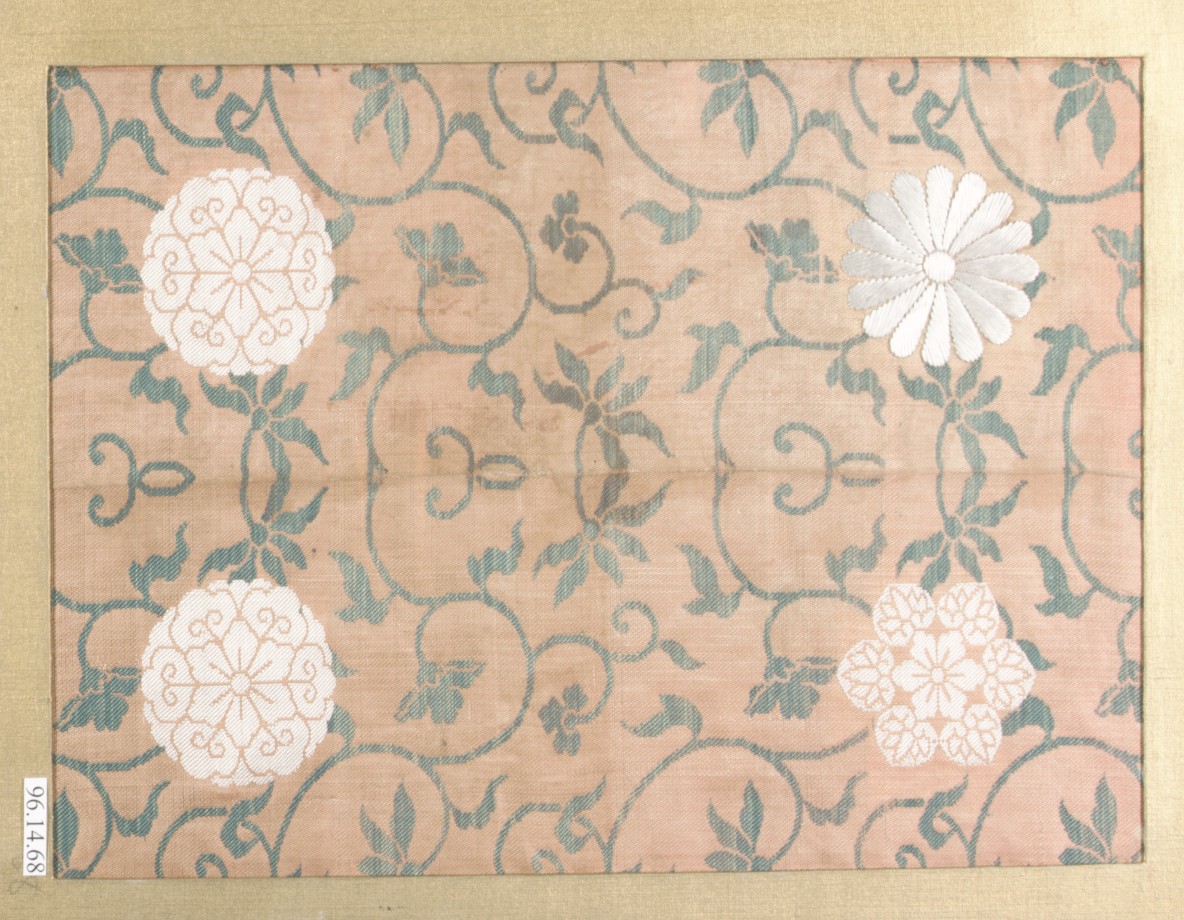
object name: piece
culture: japanese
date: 1701-1800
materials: silk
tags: flowers